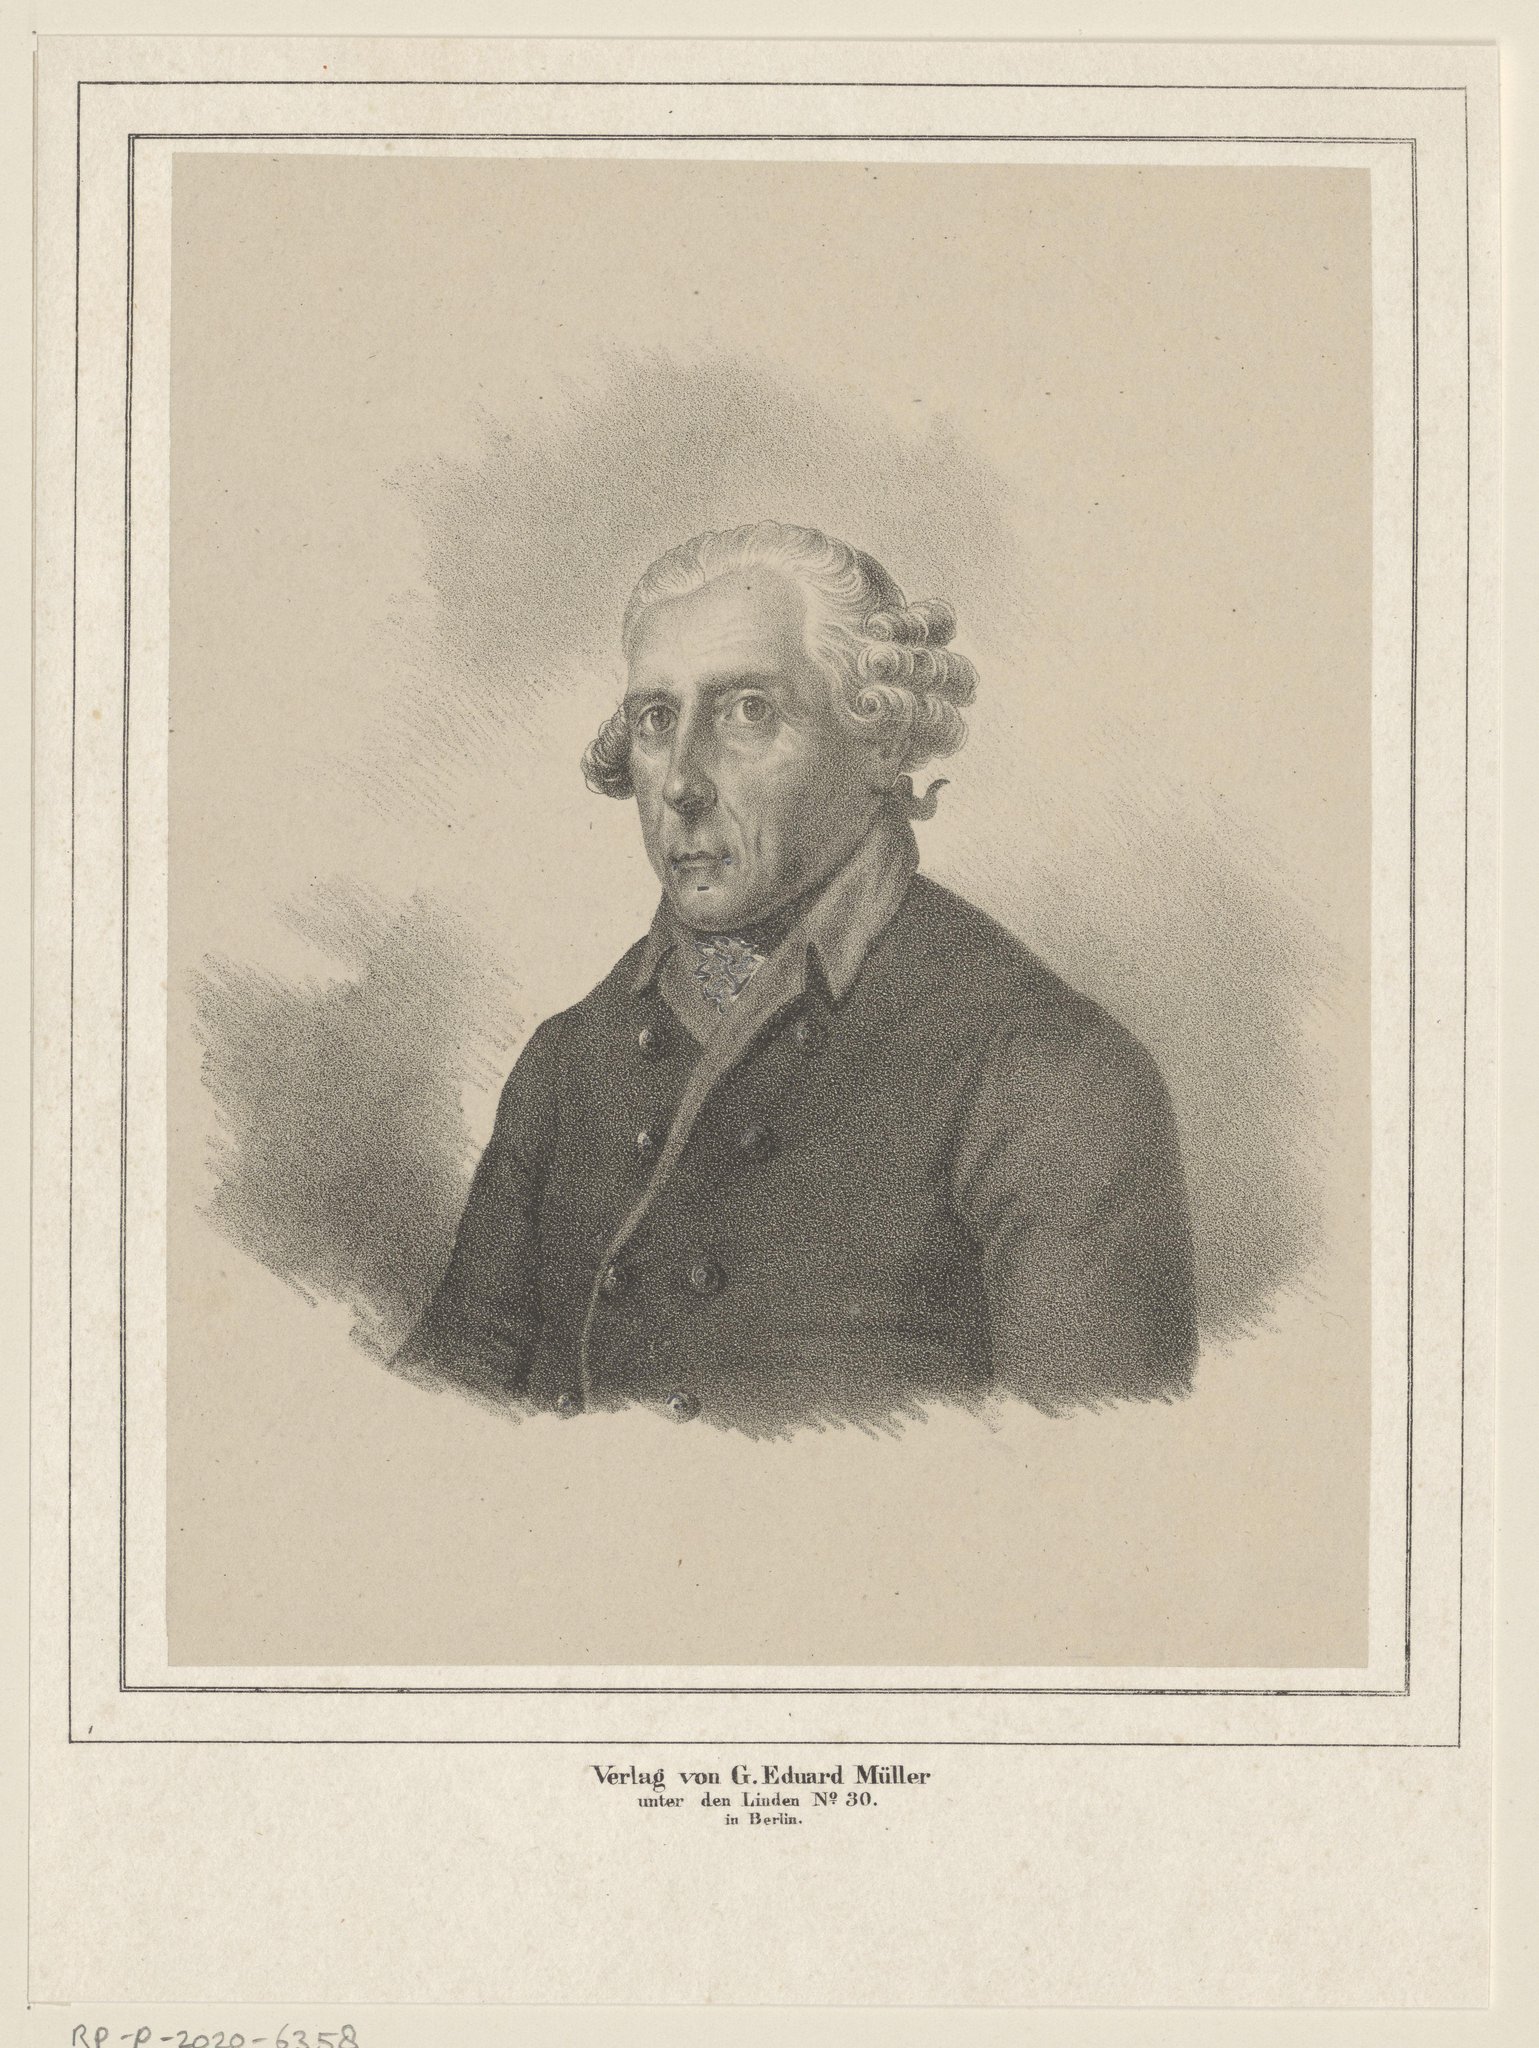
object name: print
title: Portret van Frederik de Grote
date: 1830-1899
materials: paper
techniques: lithograph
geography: germany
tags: berlin, frederick ii (king of prussia), historical persons, king